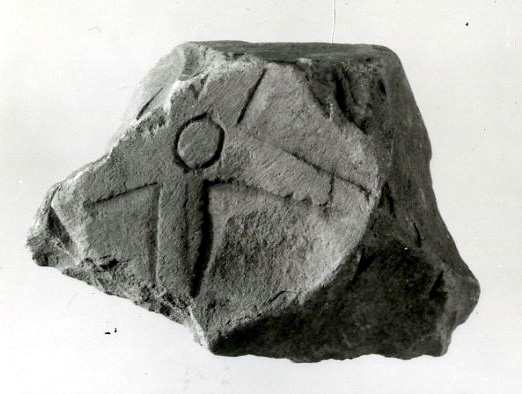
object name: relief fragment, tomb of meketre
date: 1981-1975 BCE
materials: limestone, paint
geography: egypt